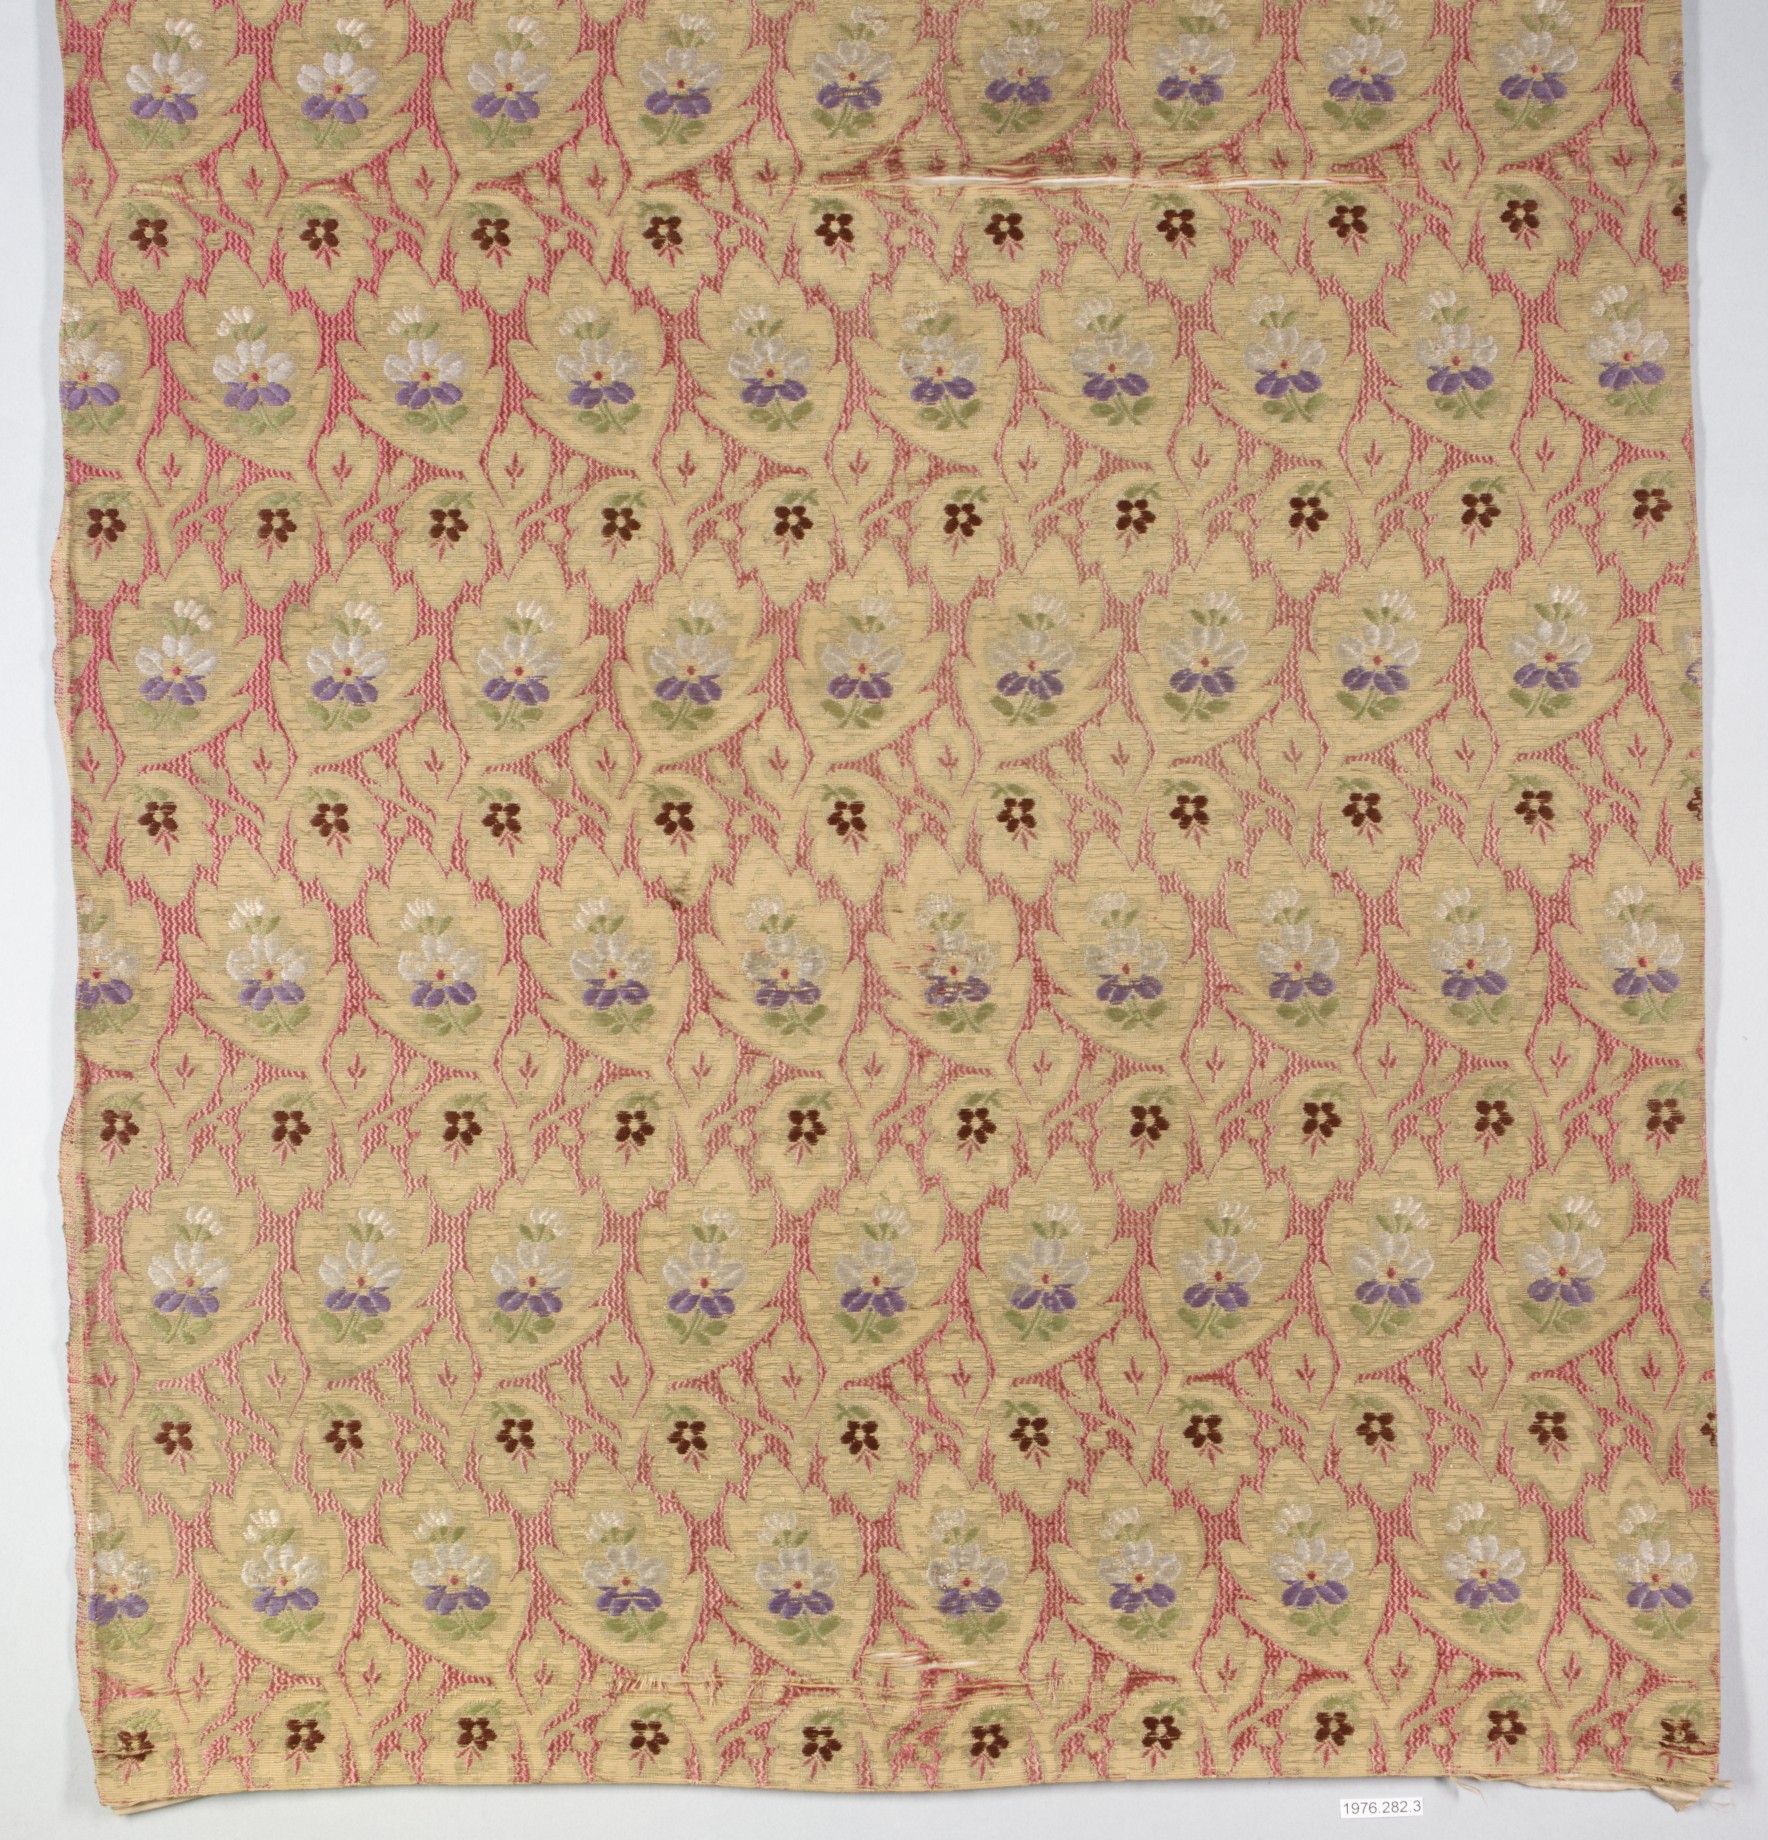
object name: length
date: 1801-1900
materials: silk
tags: flowers